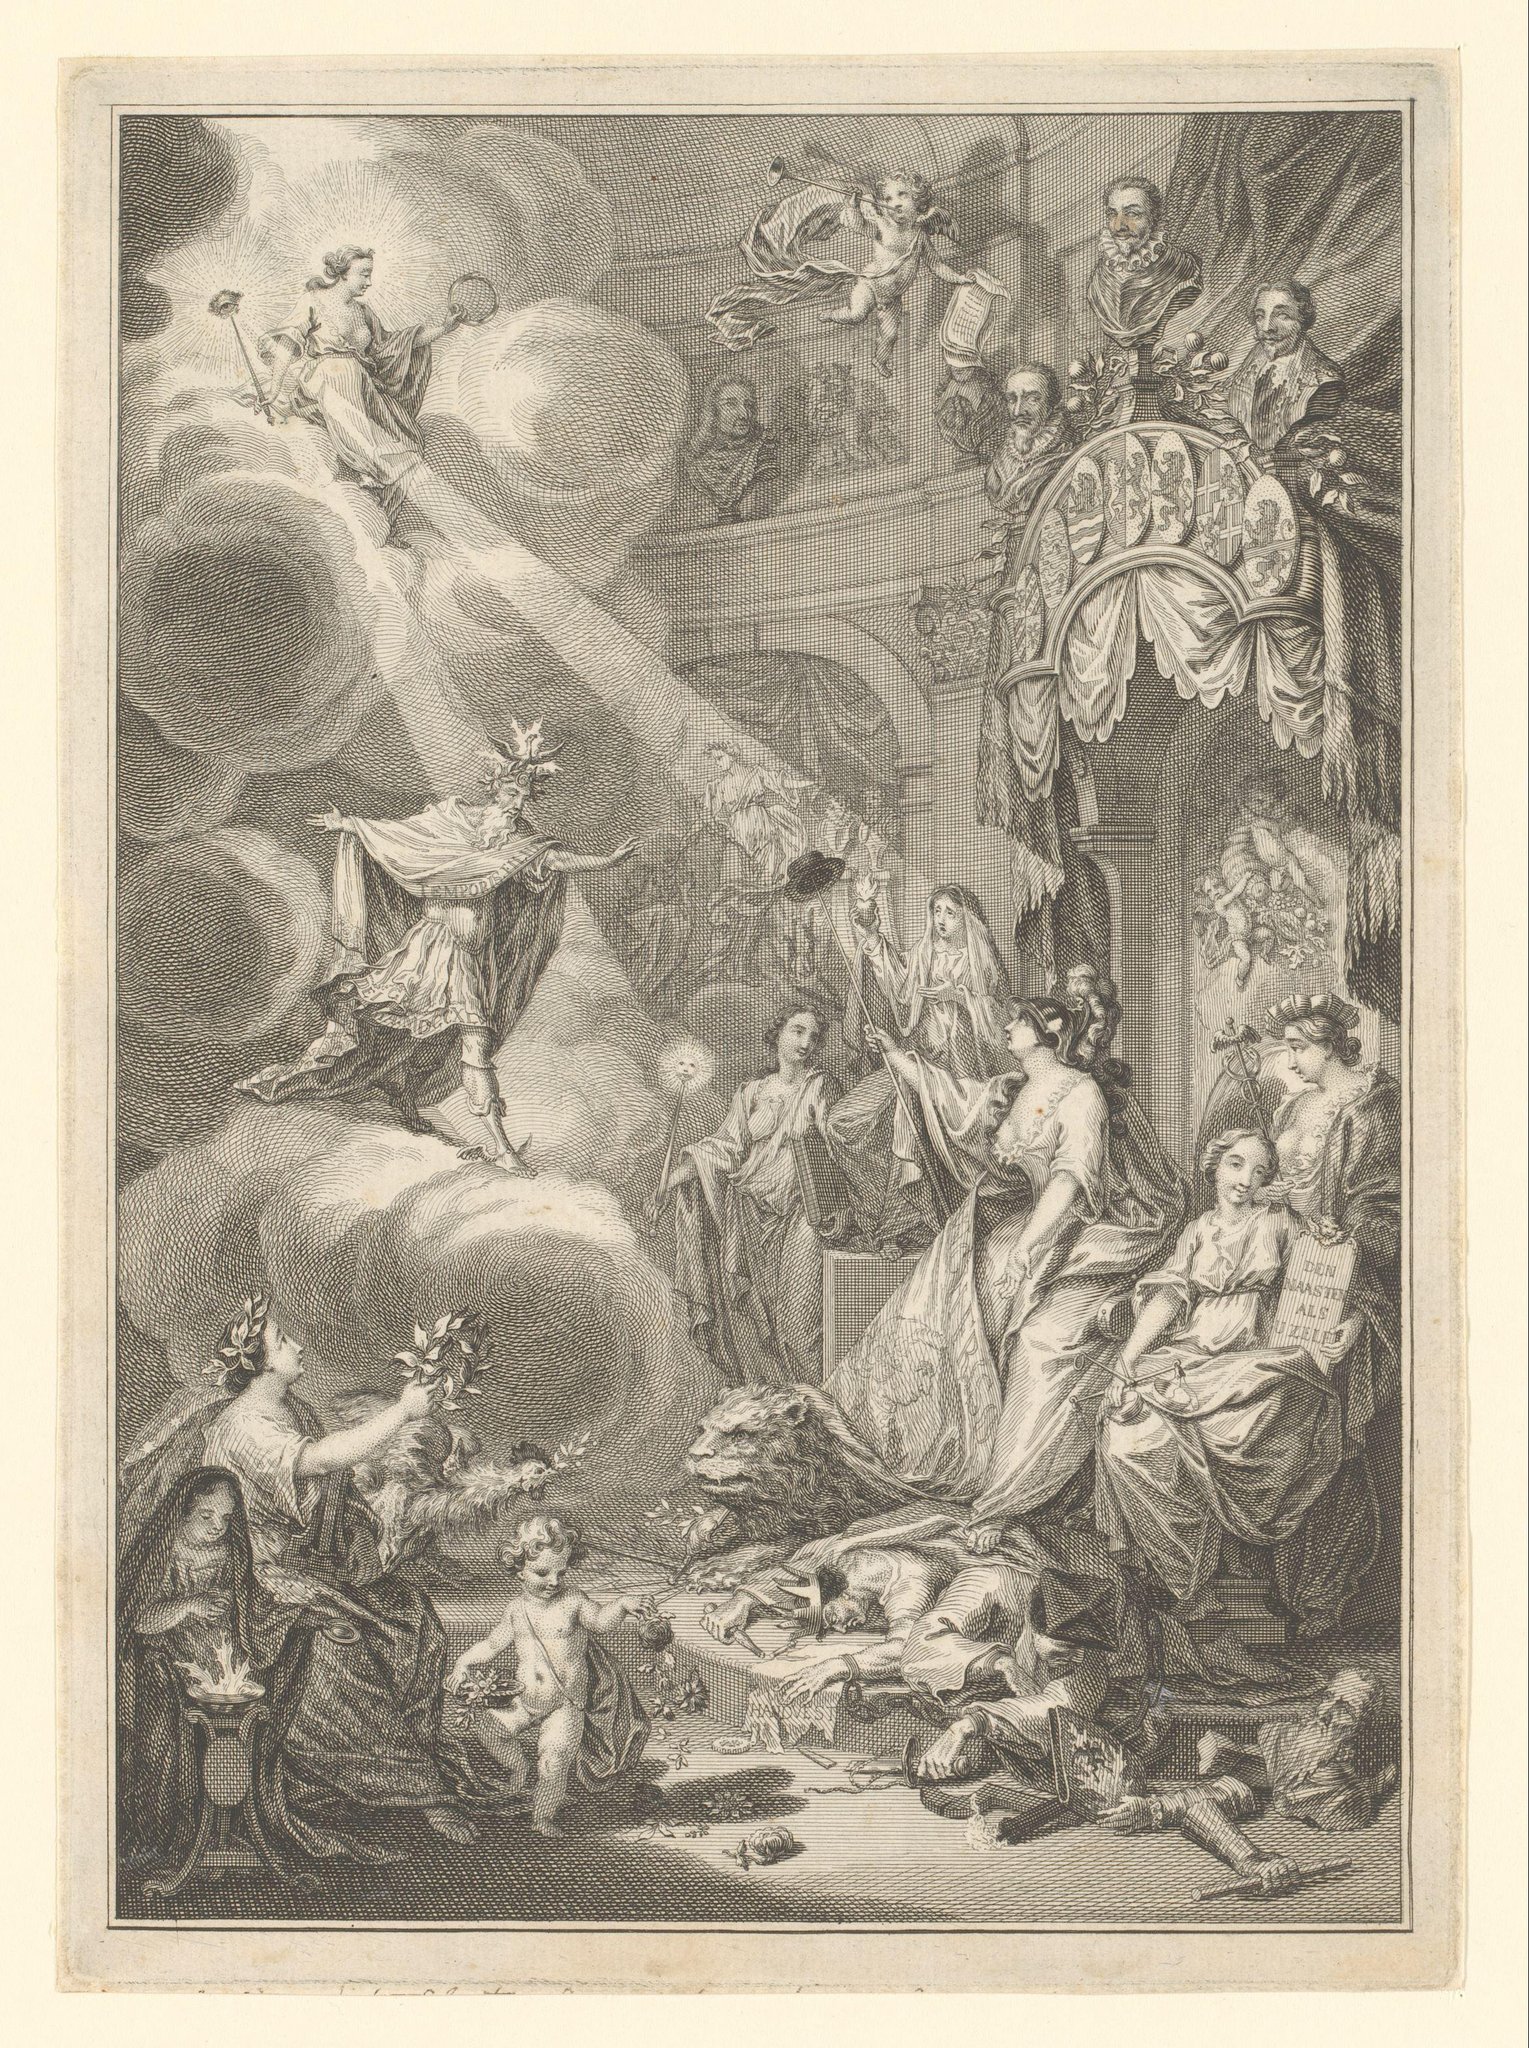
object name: print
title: Allegorie op het jubileum van Nederlands Vrijheid, 1748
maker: simon fokke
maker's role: draughtsman, print maker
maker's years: 1712-1784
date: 1748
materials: paper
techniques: engraving, etching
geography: amsterdam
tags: symbols, allegories of peace, 'pax'; 'pace' (ripa), freedom, liberty; 'libertà' (ripa)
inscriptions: collector's mark: Lugt 2228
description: Allegorie op het 100-jarig jubileum van Nederlands Vrijheid, 1648-1748. De personificatie van Nederlands Vrijheid, afgebeeld met hoed op stok, de Nederlandse leeuw en vaandel van prins Willem IV, ontvangt de personificatie van de Eeuw die uit de wolken is afgedaald. Boven de troon staan bustes van de stadhouders, aan de voeten van de Vrijheid ligt de tijdens de opstand verslagen vijand: de katholieke kerk.